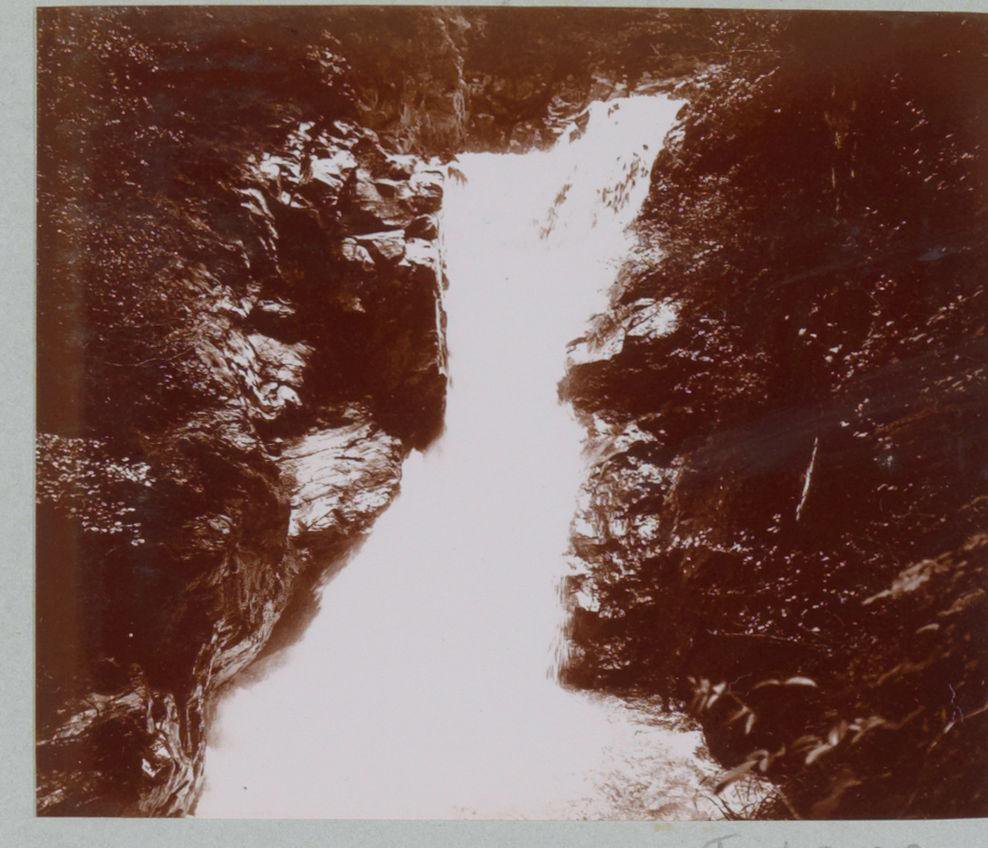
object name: photograph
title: Waterval in de Alpen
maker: Anonymous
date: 1905-1910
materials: paper, photographic support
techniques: gelatin silver print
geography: alps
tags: waterfall, rock-formations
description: Onderdeel van Fotoalbum van een Franse amateurfotograaf met bezienswaardigheden in Frankrijk, Zwitserland en Italië.